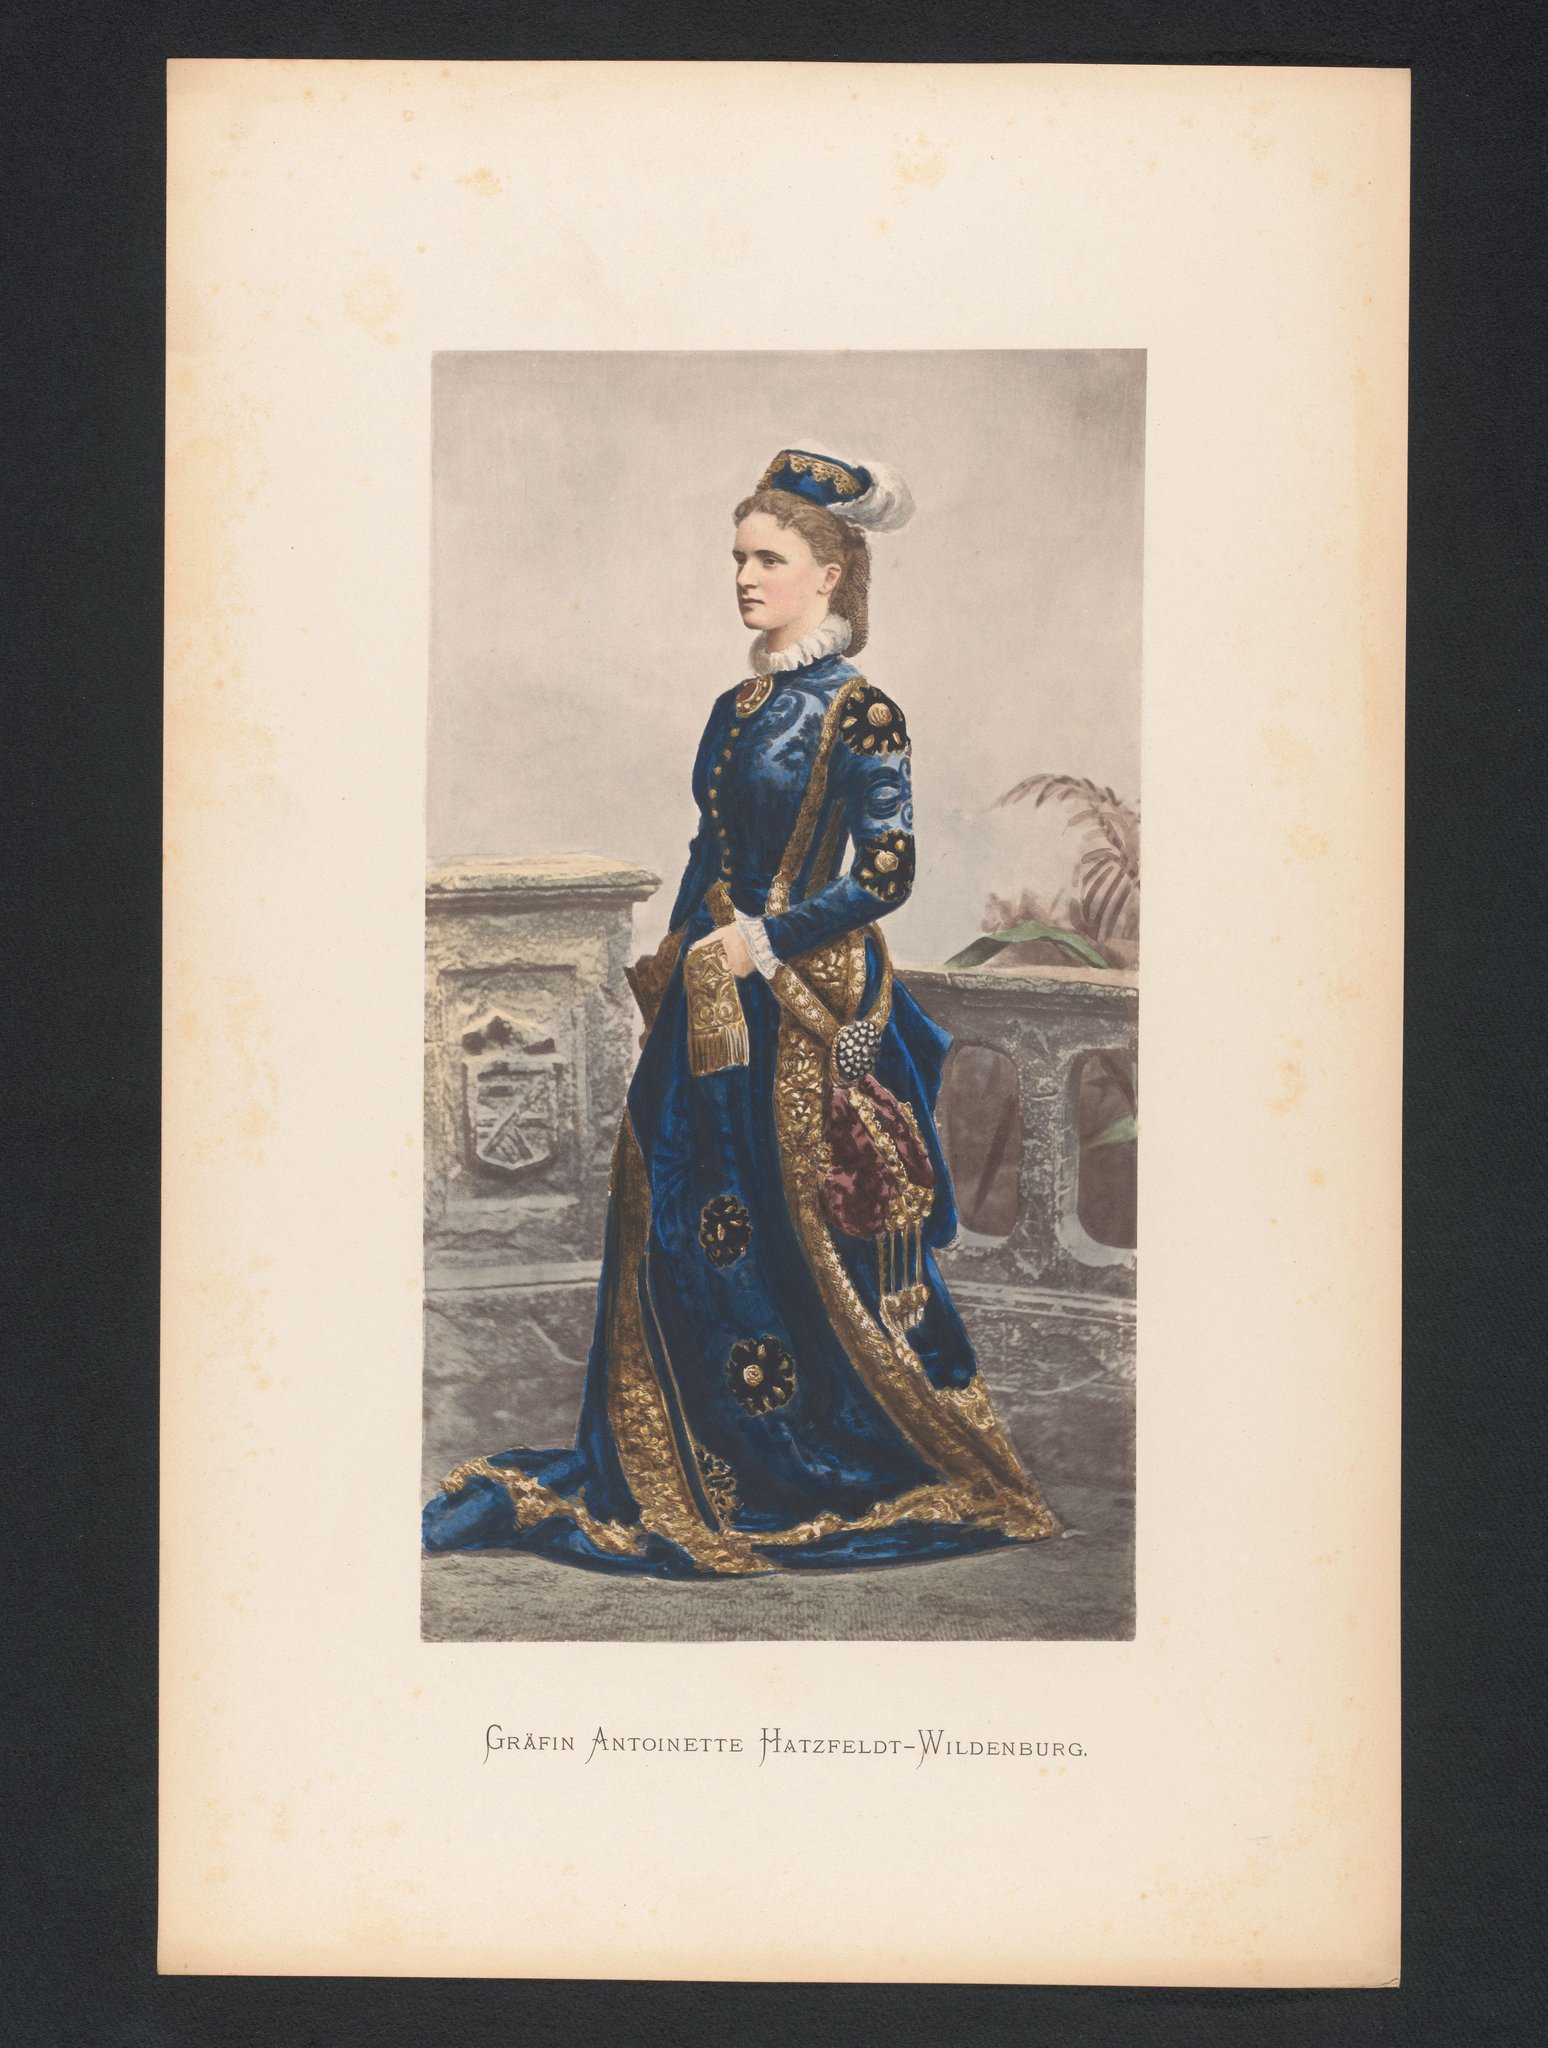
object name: photomechanical print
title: Gräfin Antoinette Hatzfeldt-Wildenburg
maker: Anonymous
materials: paper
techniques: photograph, hand coloring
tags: historical persons - bb - woman, aristocracy; 'aristocratia' (ripa)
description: Deze prent maakt deel uit van een omslag met 86 prenten op 78 bladen en 11 tekstbladen.